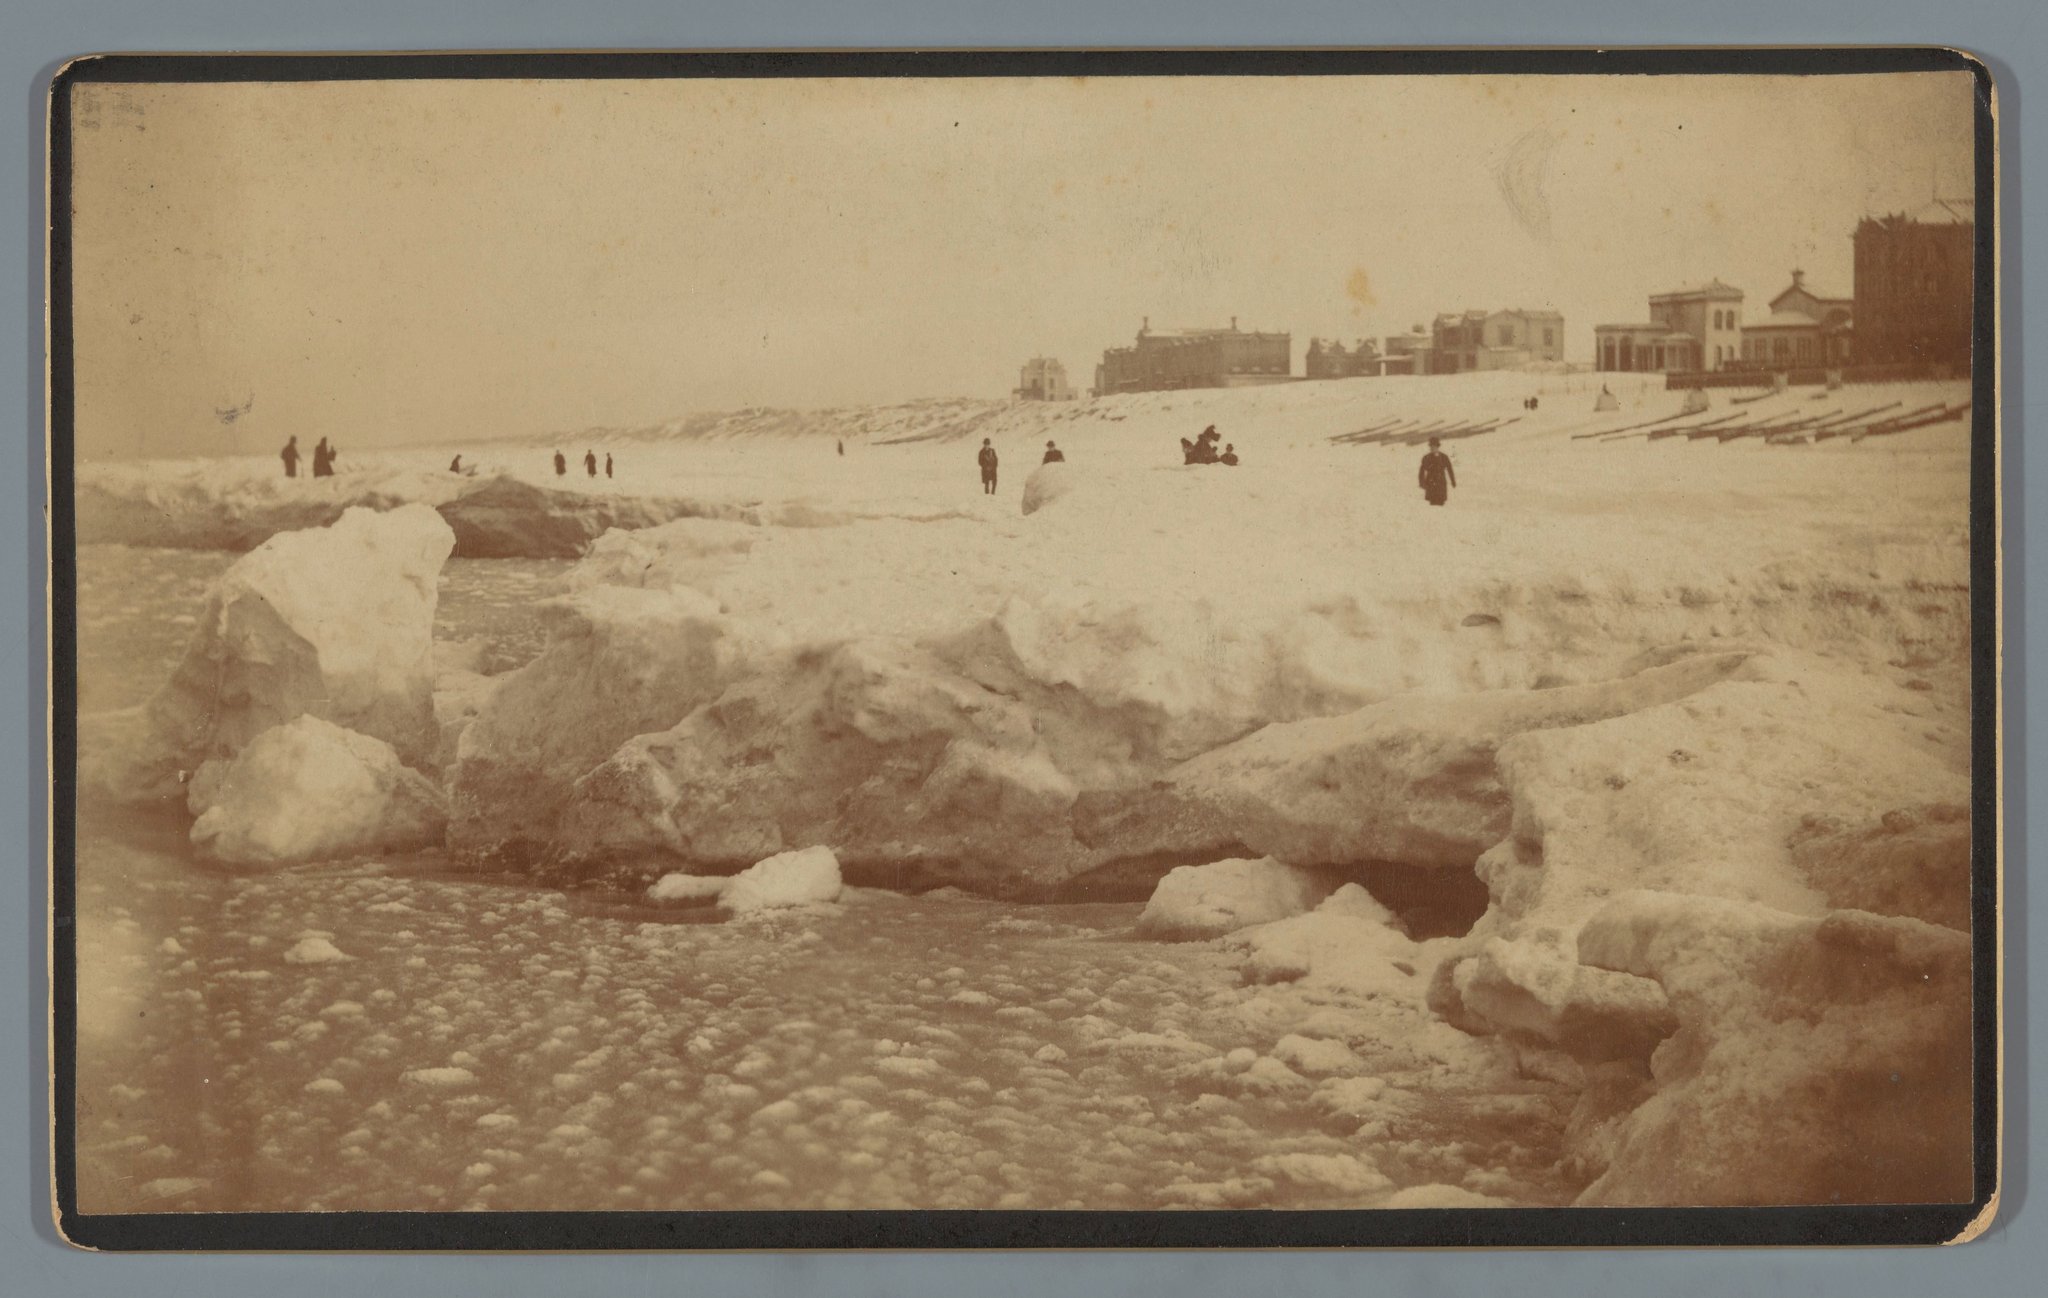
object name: photograph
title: Gezicht op het strand van Scheveningen met pakijs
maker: Anonymous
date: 1801-1891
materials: cardboard, paper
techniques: albumen print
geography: scheveningen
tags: winter landscape; landscape symbolizing winter (the four seasons of the year), beach, drift ice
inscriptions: number: ‘125’, inscription: ‘Scheveningen Januari 1891’